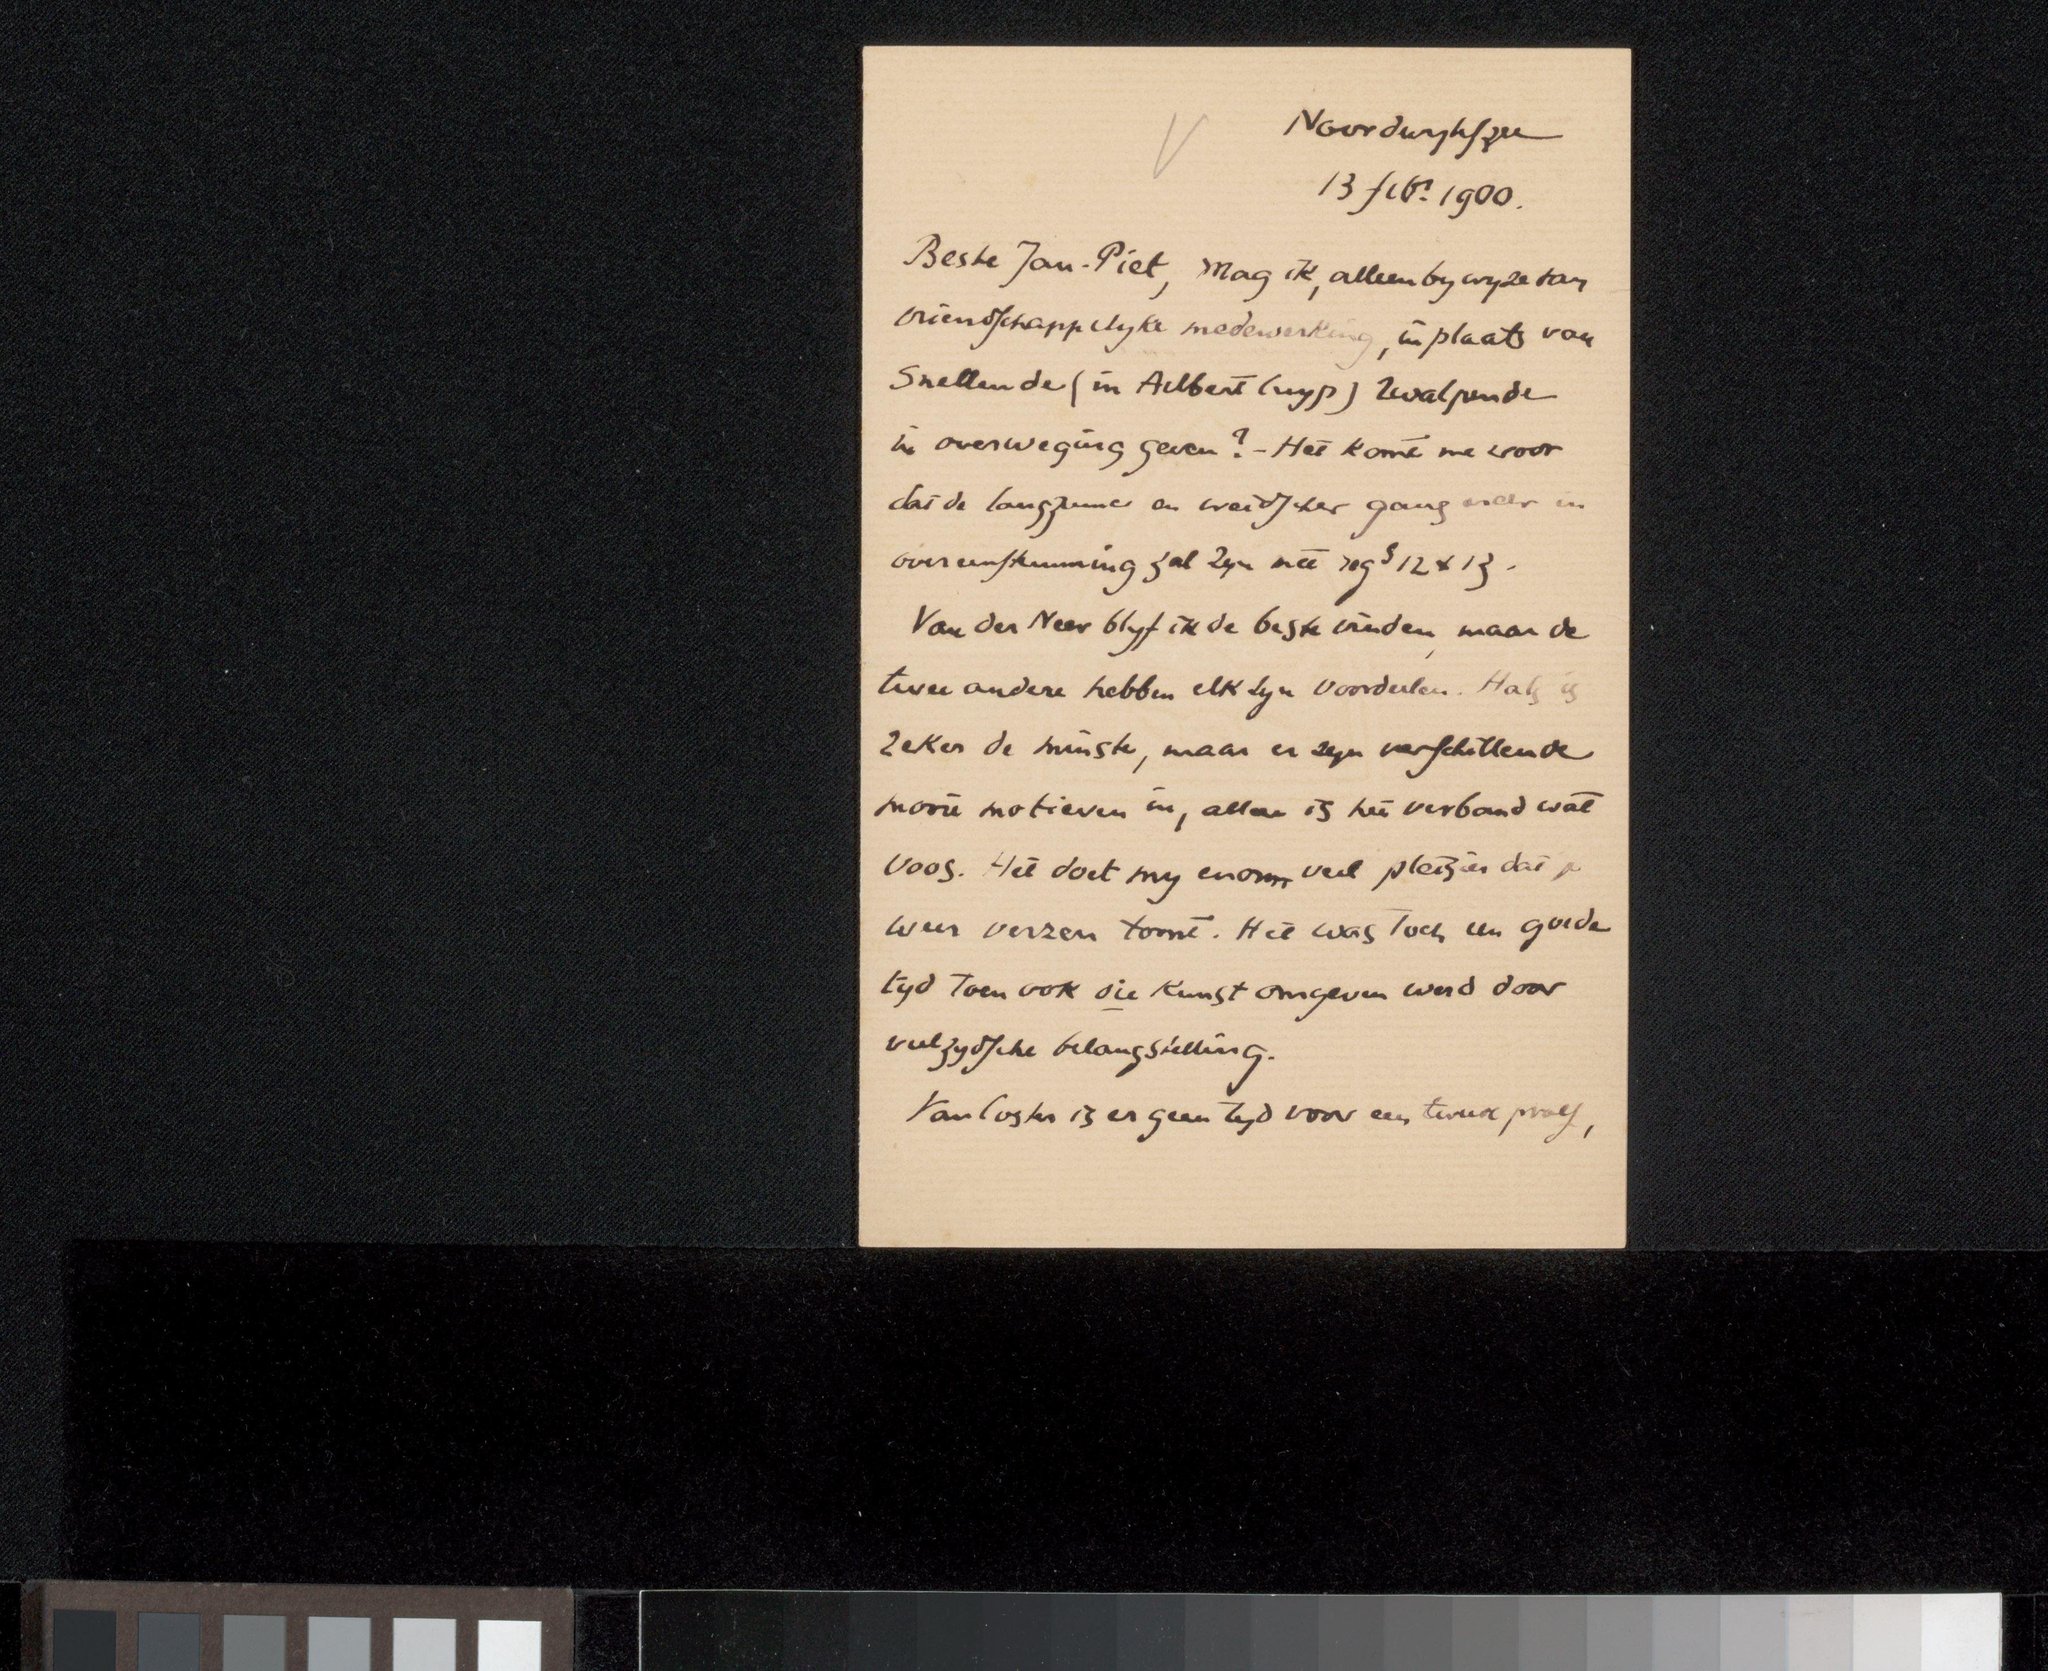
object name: letter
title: Brief aan Jan Veth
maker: albert verwey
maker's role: criticus, dichter, essayist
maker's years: 1865-1937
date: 1900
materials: ink, paper, pencil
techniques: pen, writing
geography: noordwijk aan zee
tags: amsterdam, painter, aert van der neer, print maker, draughtsman, jan veth, antwerp, frans hals, hendrik petrus berlage, literature ~ arts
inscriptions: watermark, collector's mark: ‘RPK’